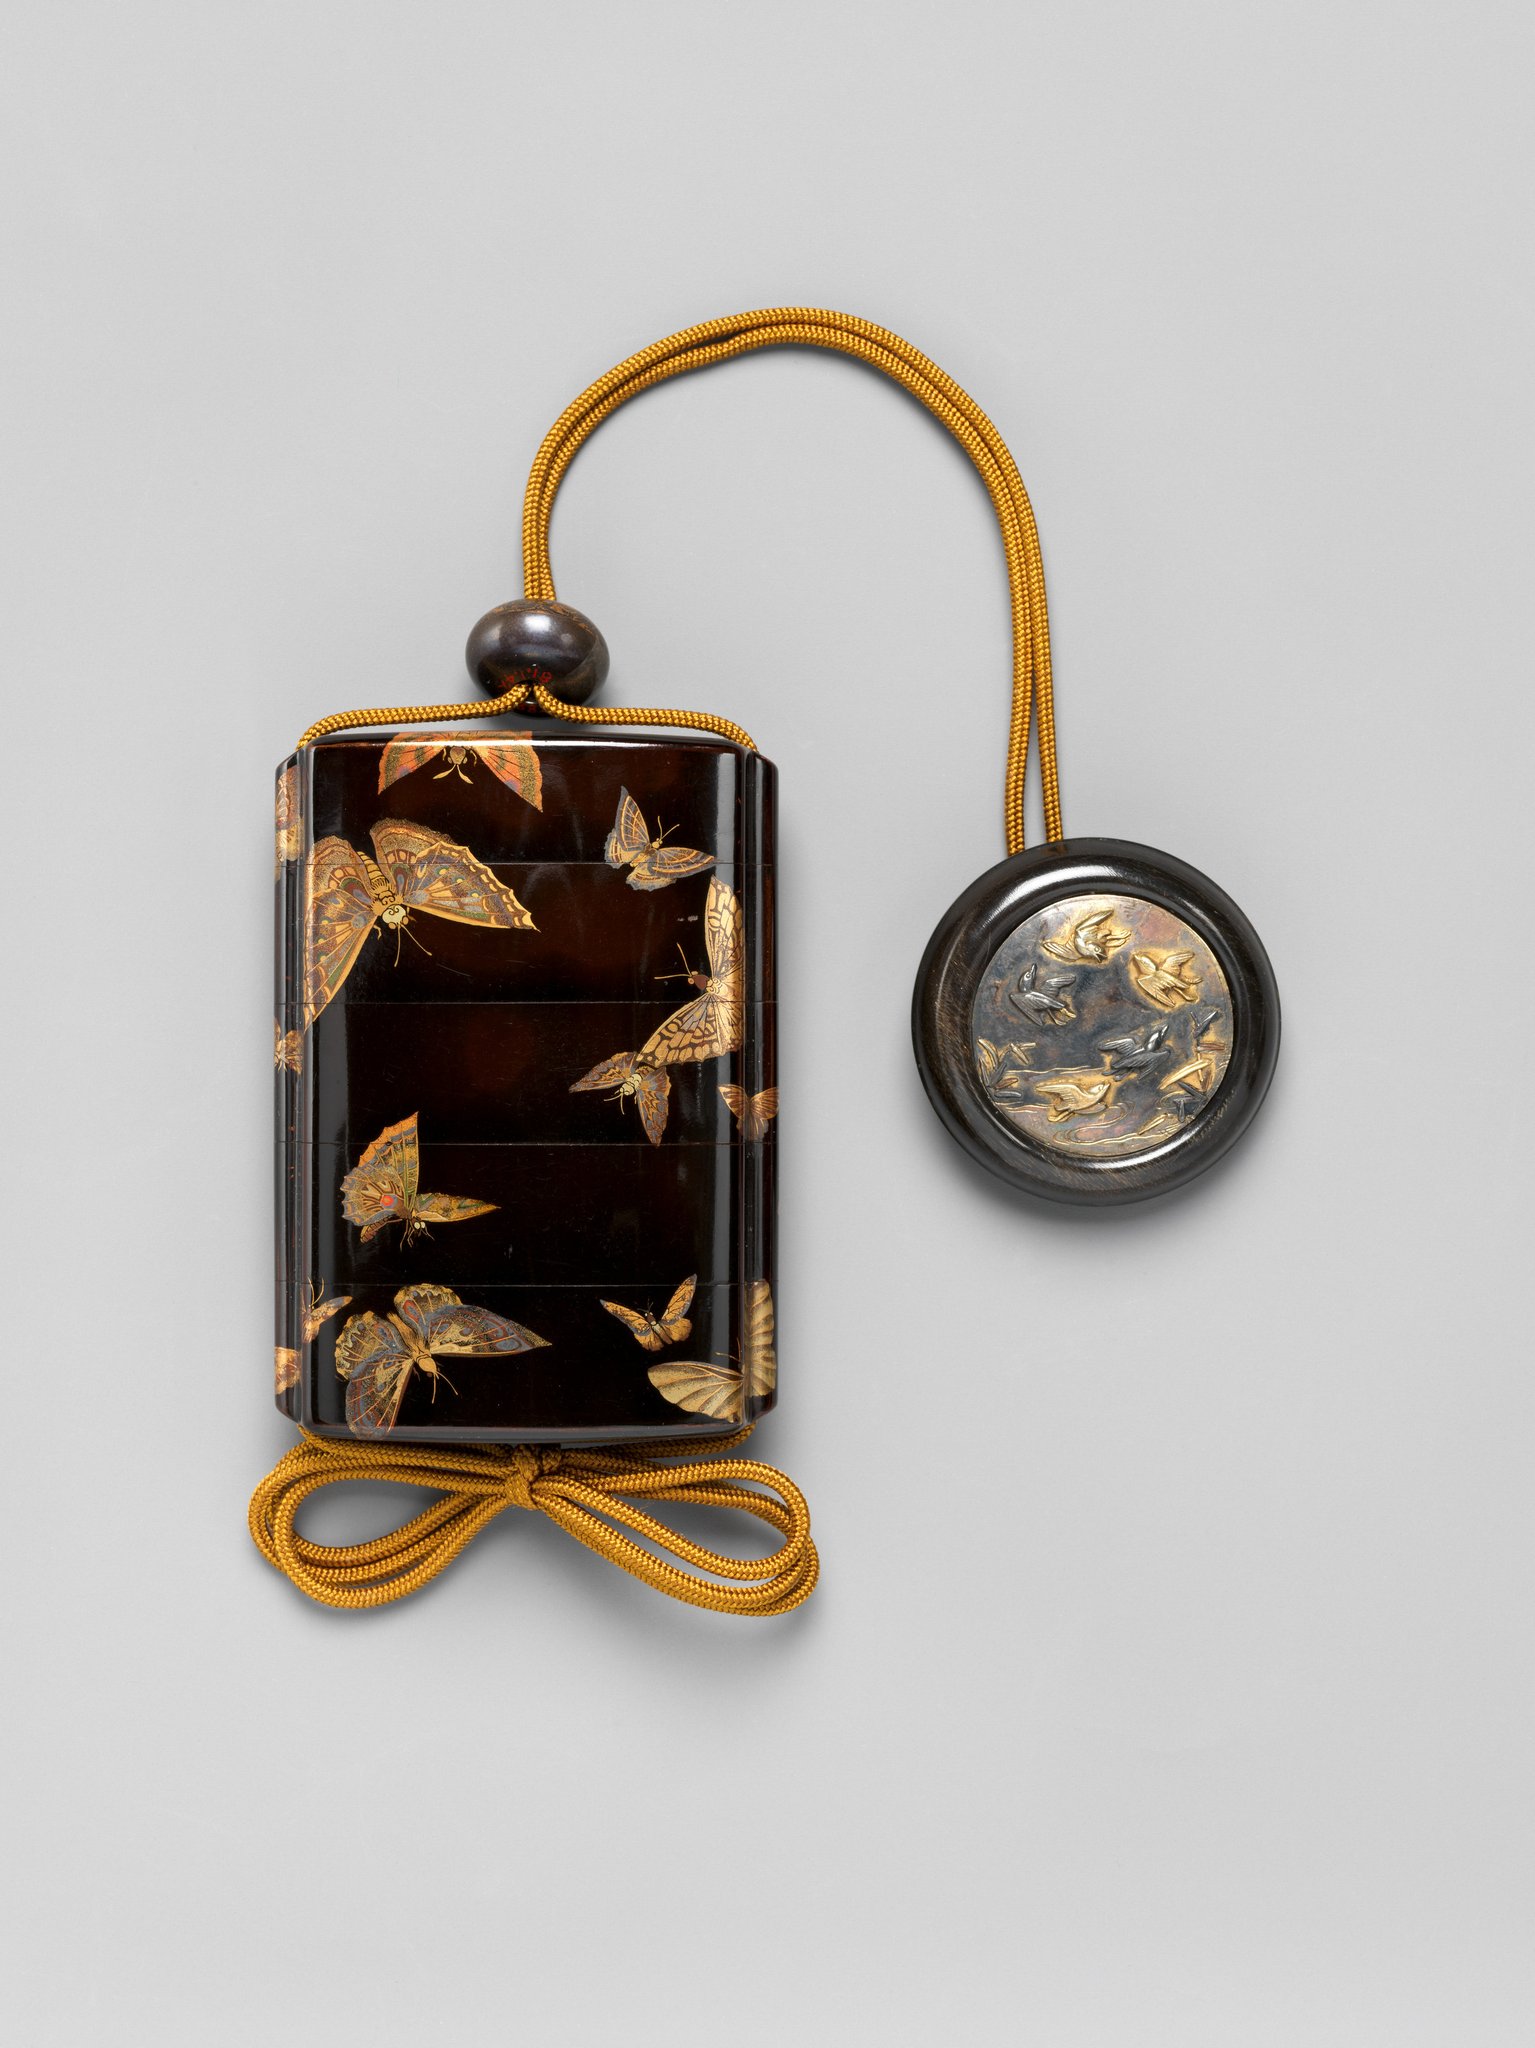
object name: inrō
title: Case (Inrō) with Design of Butterflies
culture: japanese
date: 1801-1900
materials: gold, lacquer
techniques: fundame, roiro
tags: butterflies